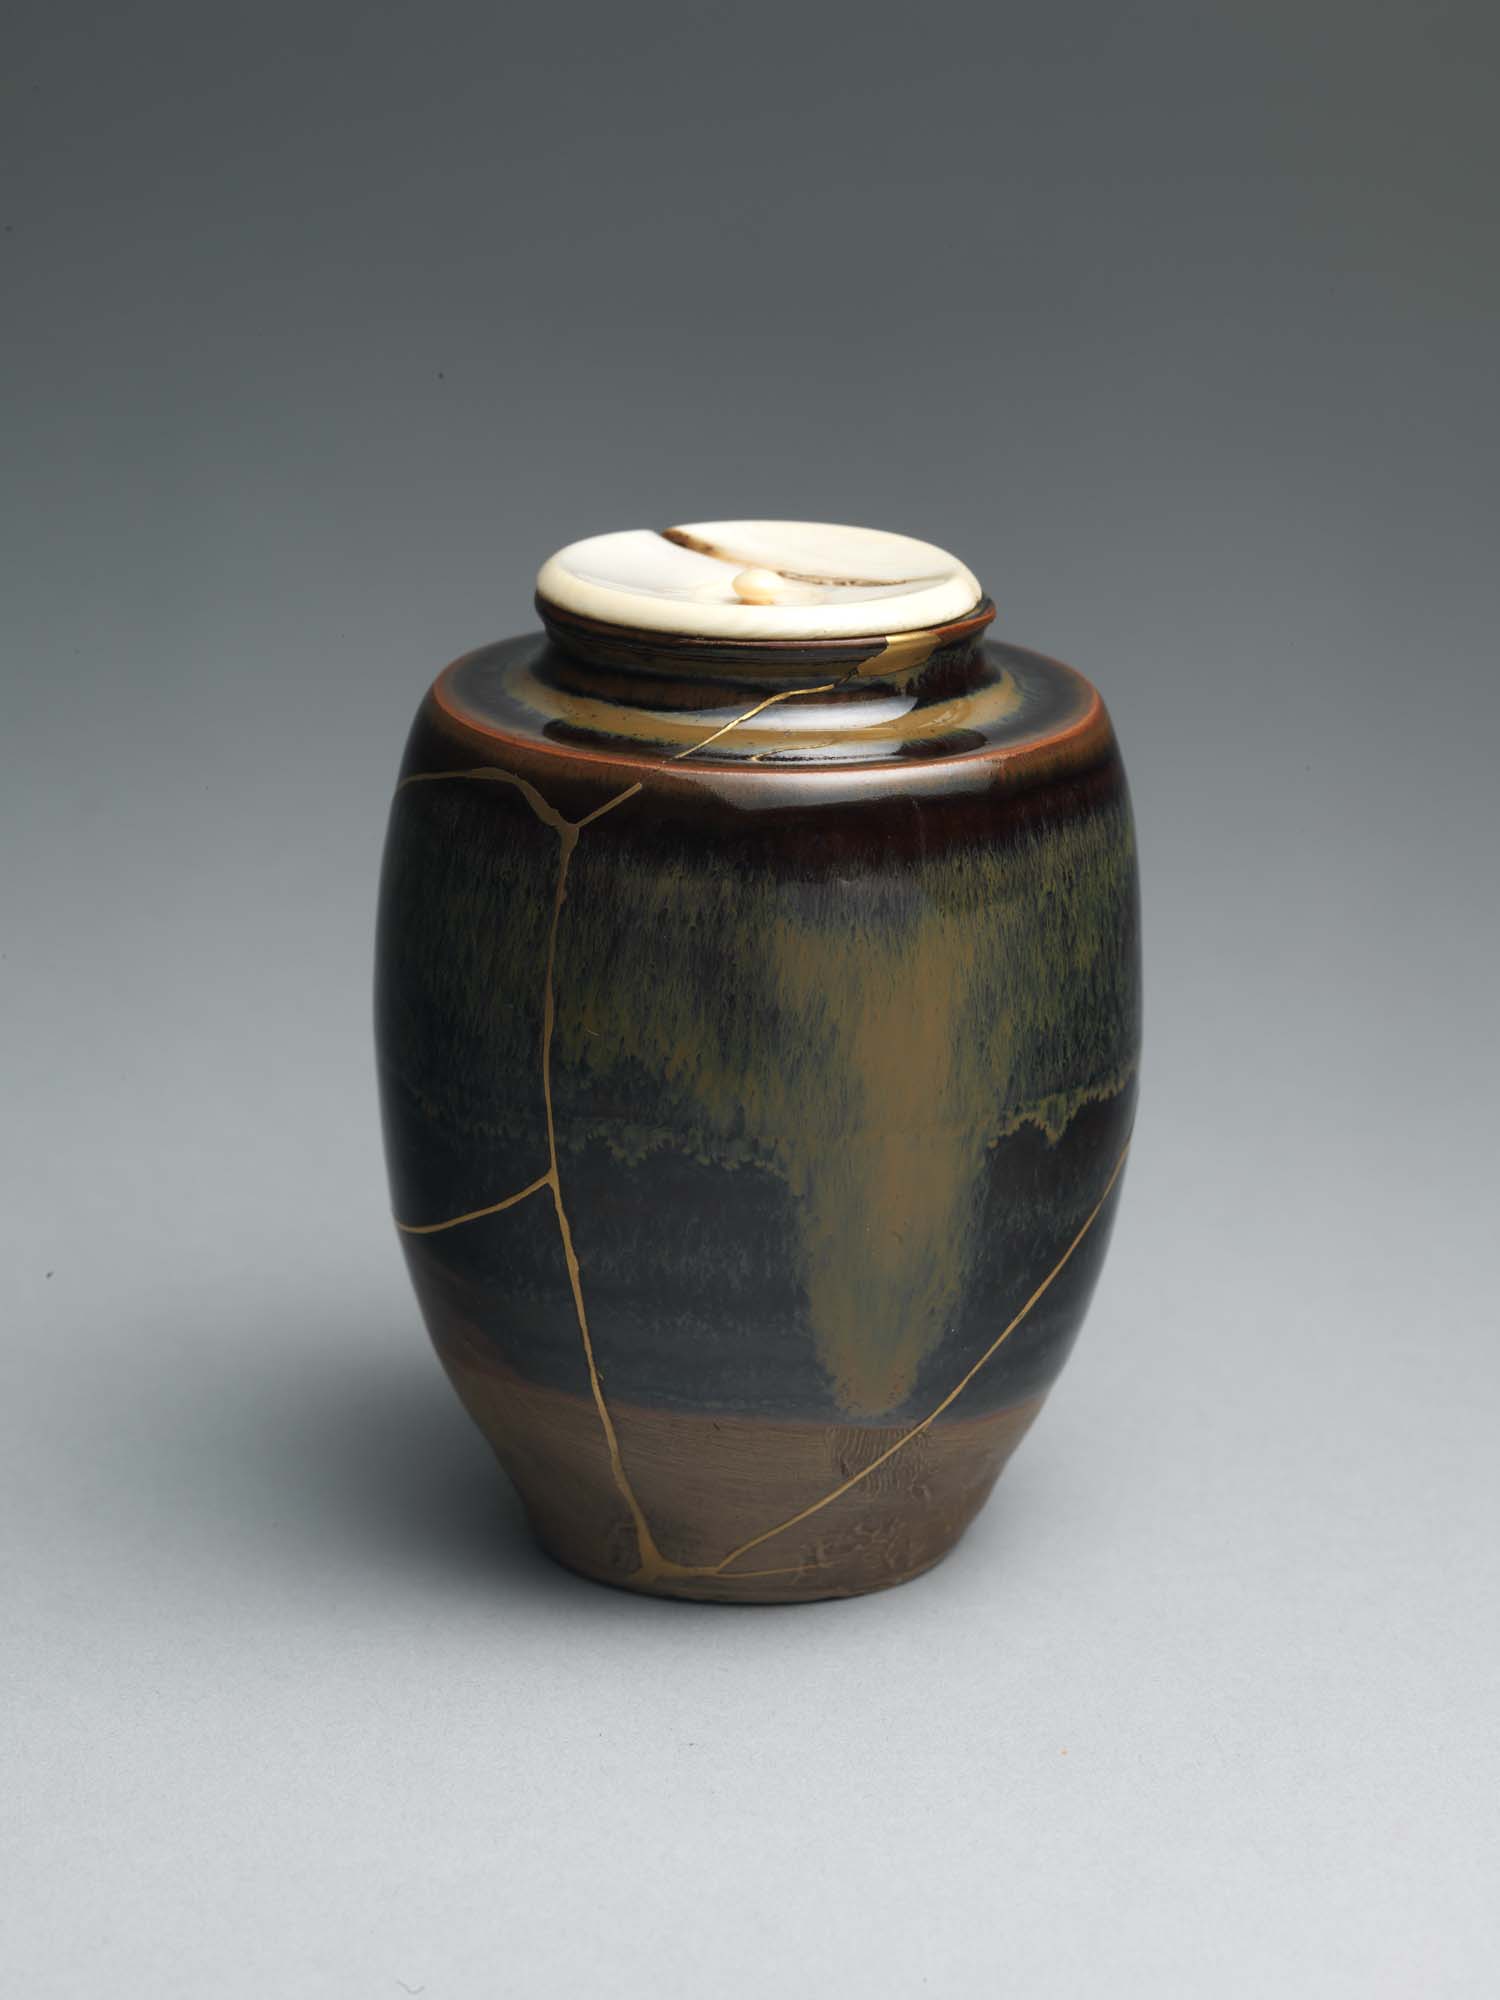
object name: tea jar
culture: japanese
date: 1701-1800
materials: clay, glaze, ivory